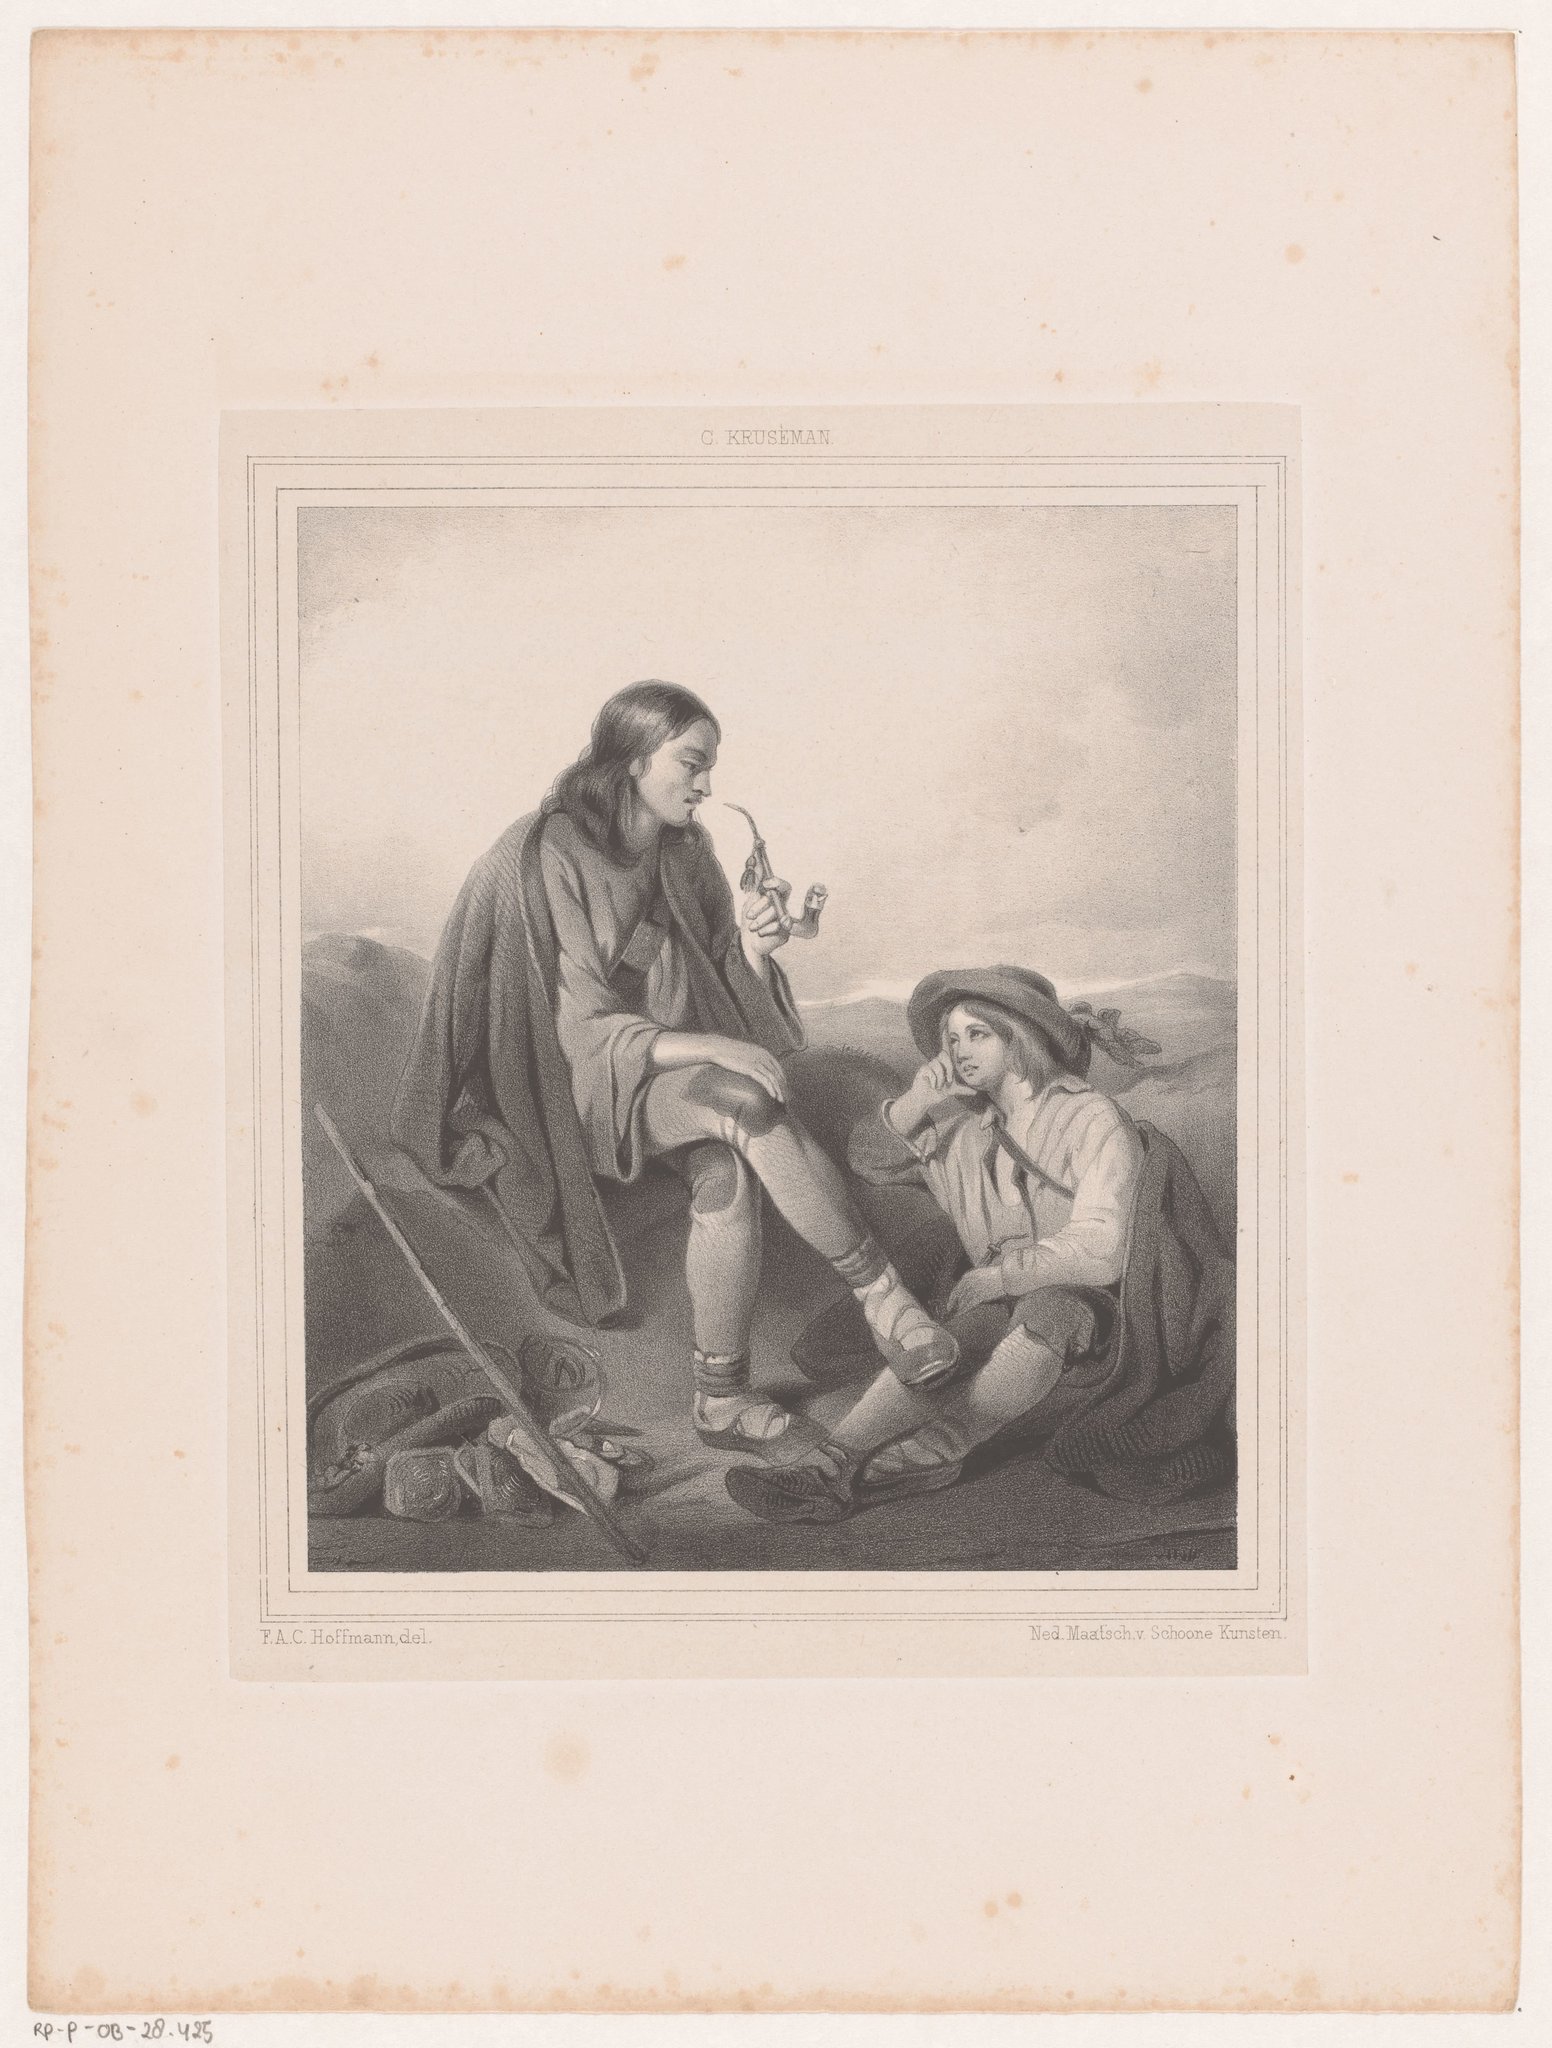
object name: print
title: Pijprokende man en jongen in landschap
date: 1840-1843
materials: paper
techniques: lithograph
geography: netherlands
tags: herding, herdsman, herdswoman, shepherd, shepherdess, cowherd, etc., pipe ~ tobacco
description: De man, mogelijk een herder, heeft zijn benen over elkaar geslagen en zijn hoed afgezet. De jongen kijkt naar hem.